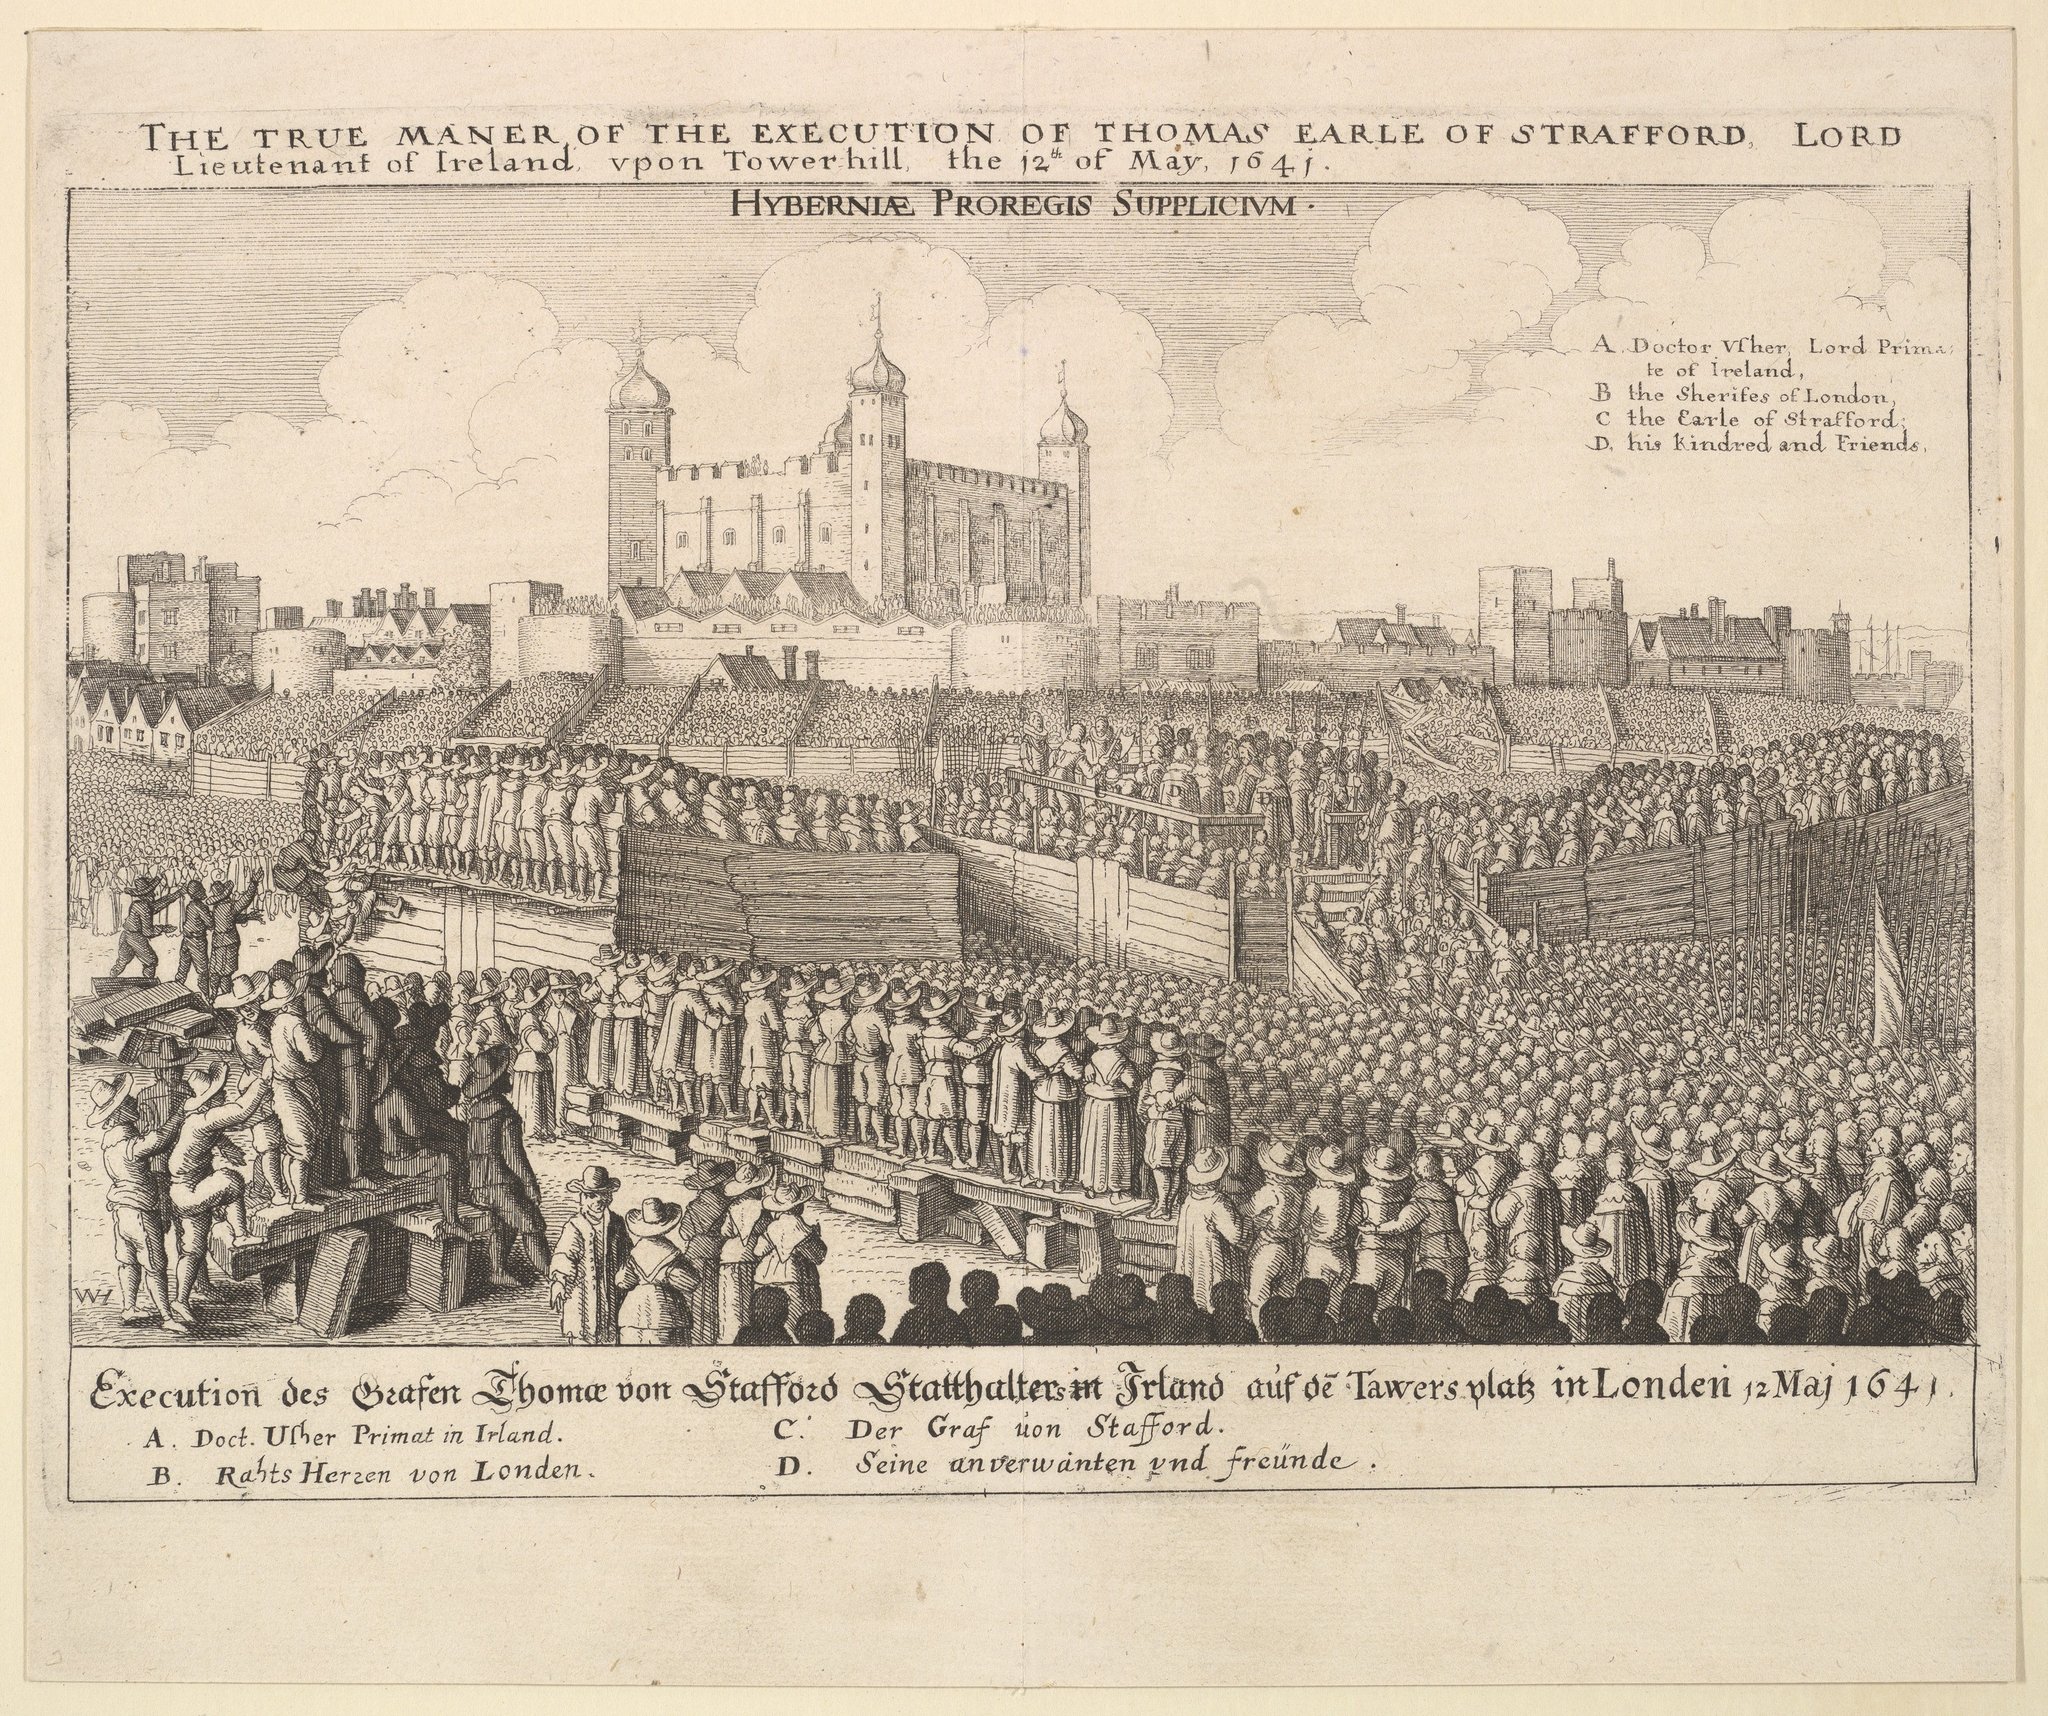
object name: print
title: The true maner [manner] of the execution of Thomas Earle of Strafford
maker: wenceslaus hollar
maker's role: artist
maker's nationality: bohemian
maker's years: 1607-1677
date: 1641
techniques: etching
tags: fortification,crowd,execution,london